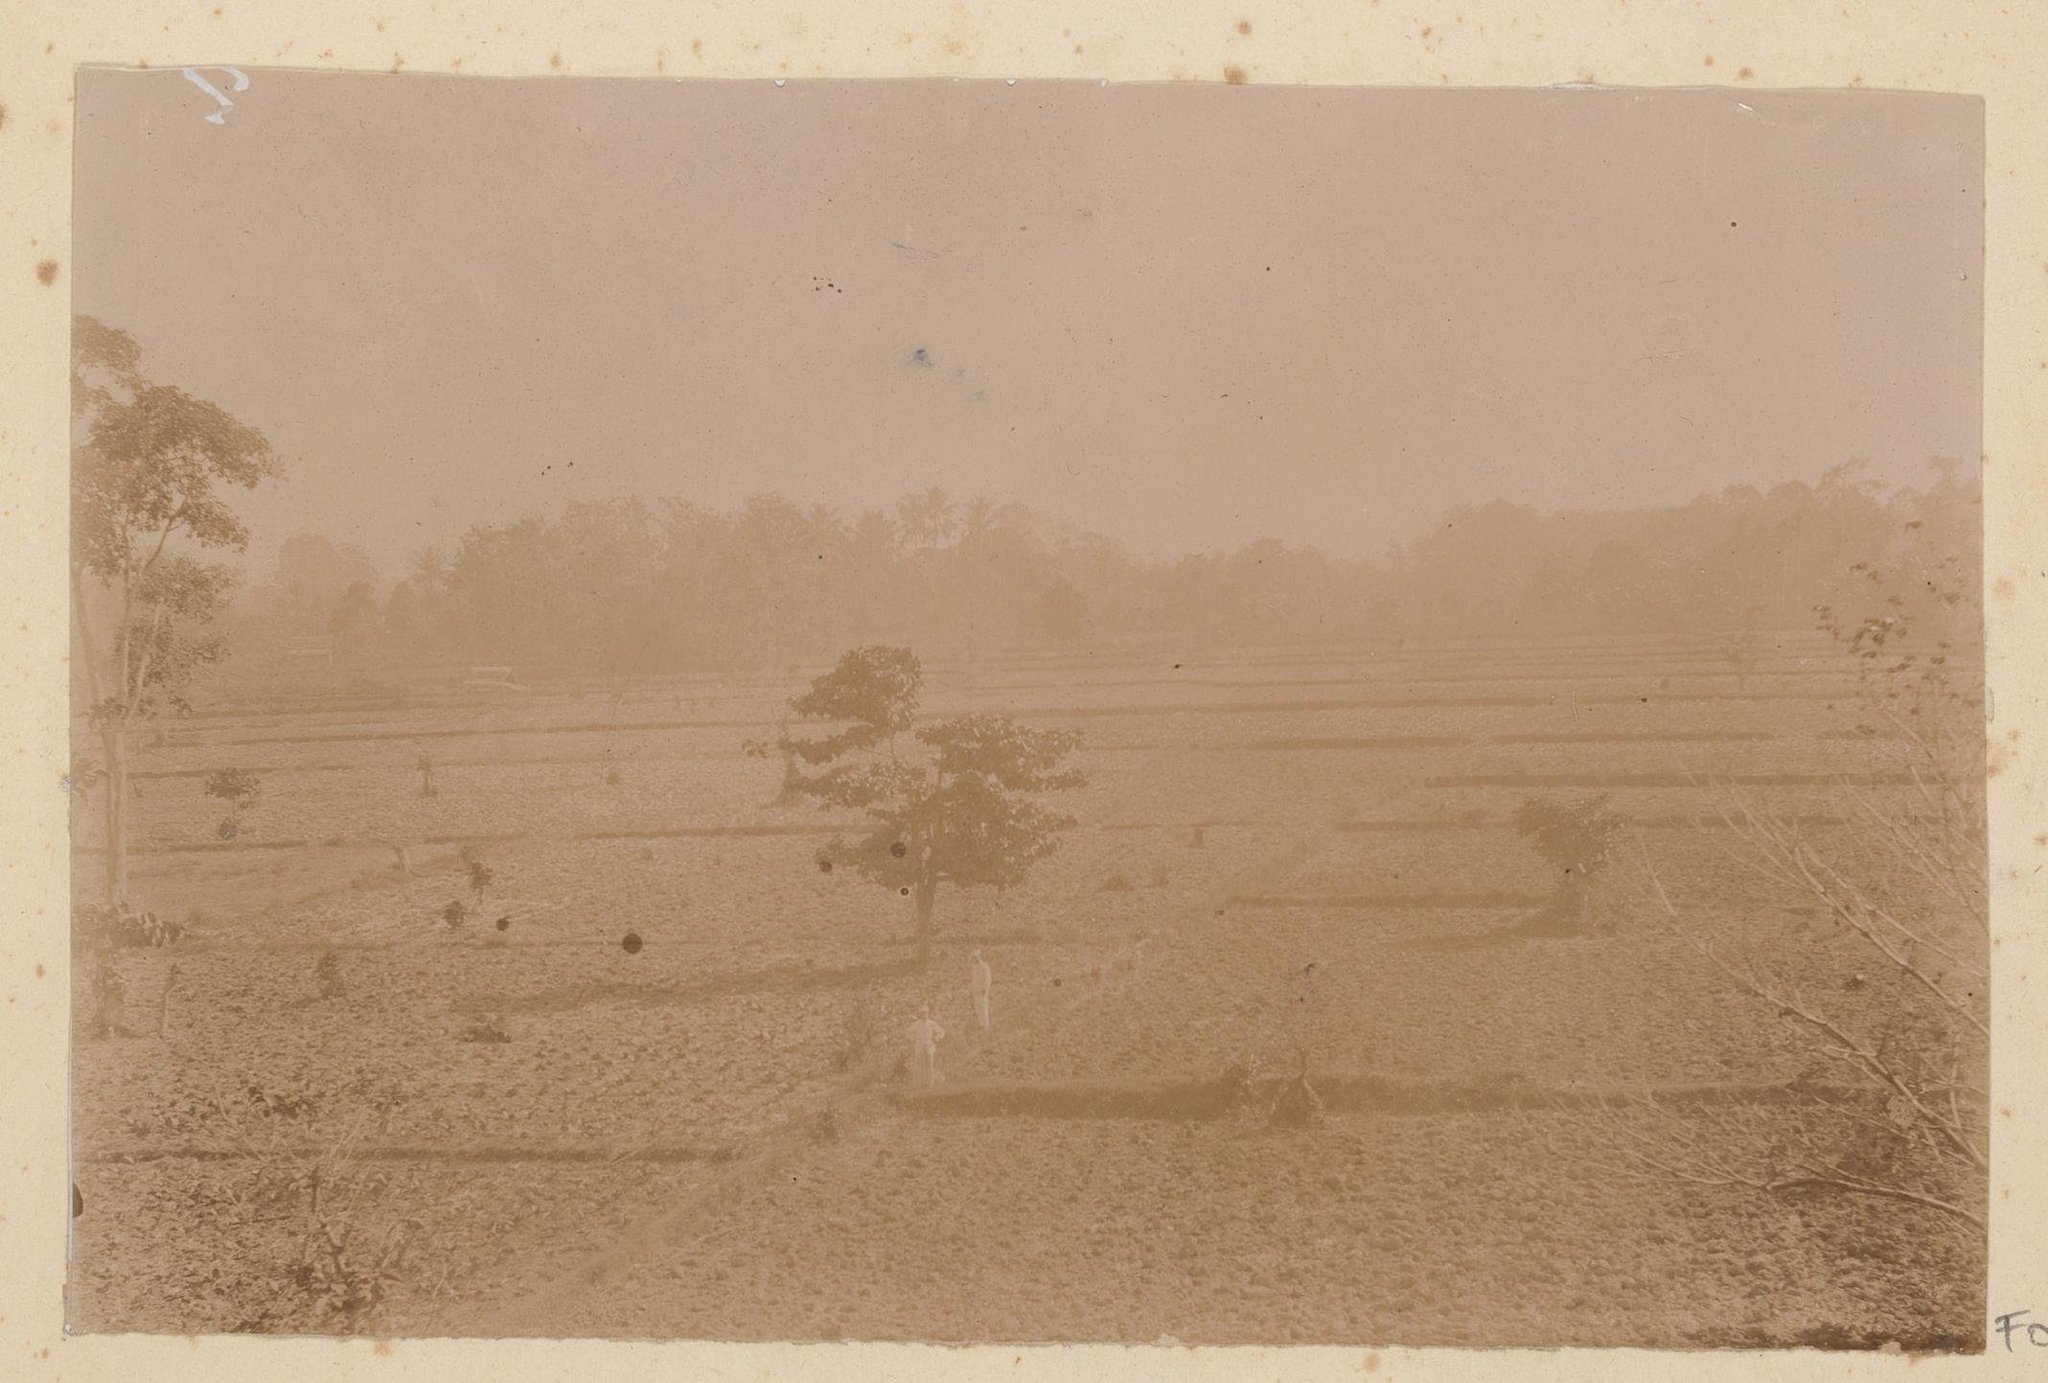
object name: photograph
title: Gezicht op een plantage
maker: Anonymous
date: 1890-1910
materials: photographic support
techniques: daylight paper print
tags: plantation, dutch east indies, the